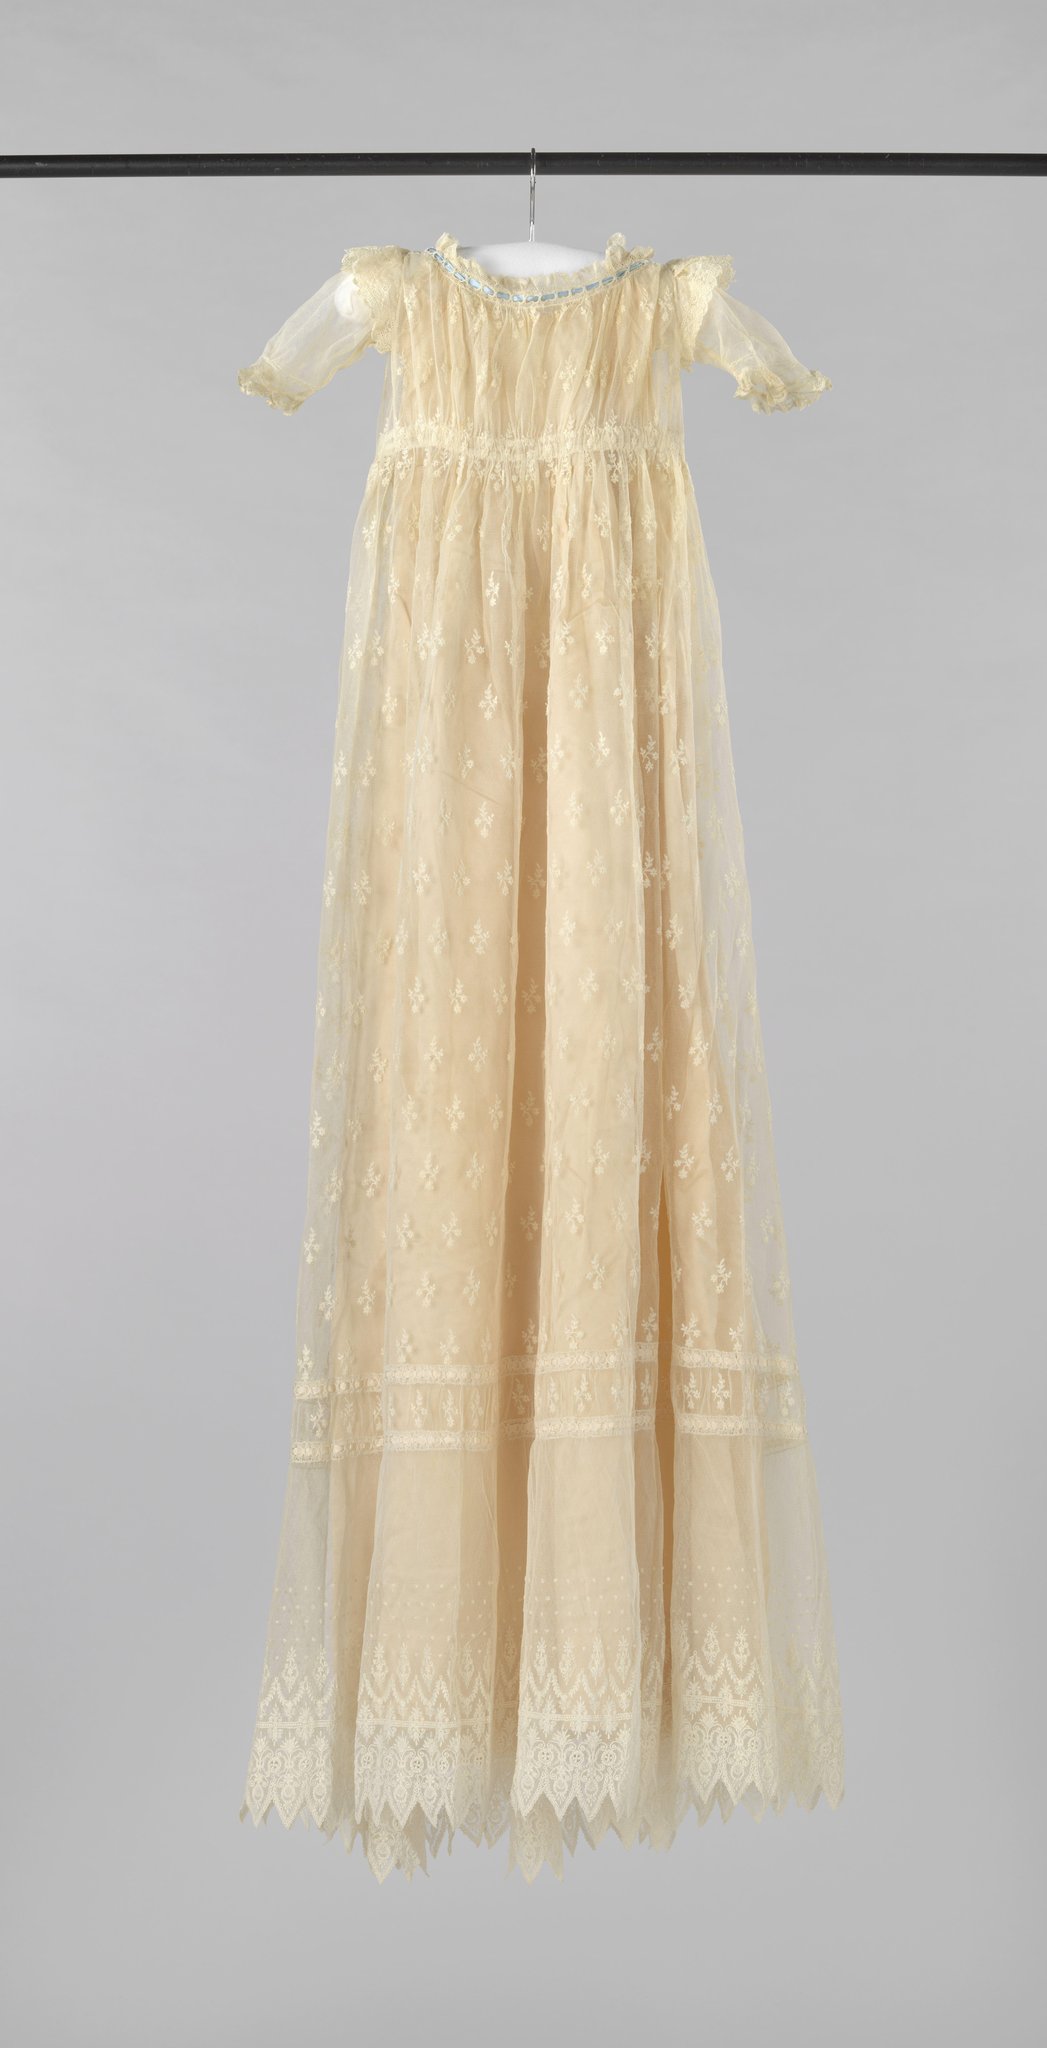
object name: ribbon material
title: Lichtblauw lint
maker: Anonymous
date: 1850-1920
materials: silk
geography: netherlands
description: Lichtblauw lint behorende bij doopjurk met tuledoorstop en onderjurk van zijde. Door de hals is een blauw lint geregen, rond het middel twee beige linten.